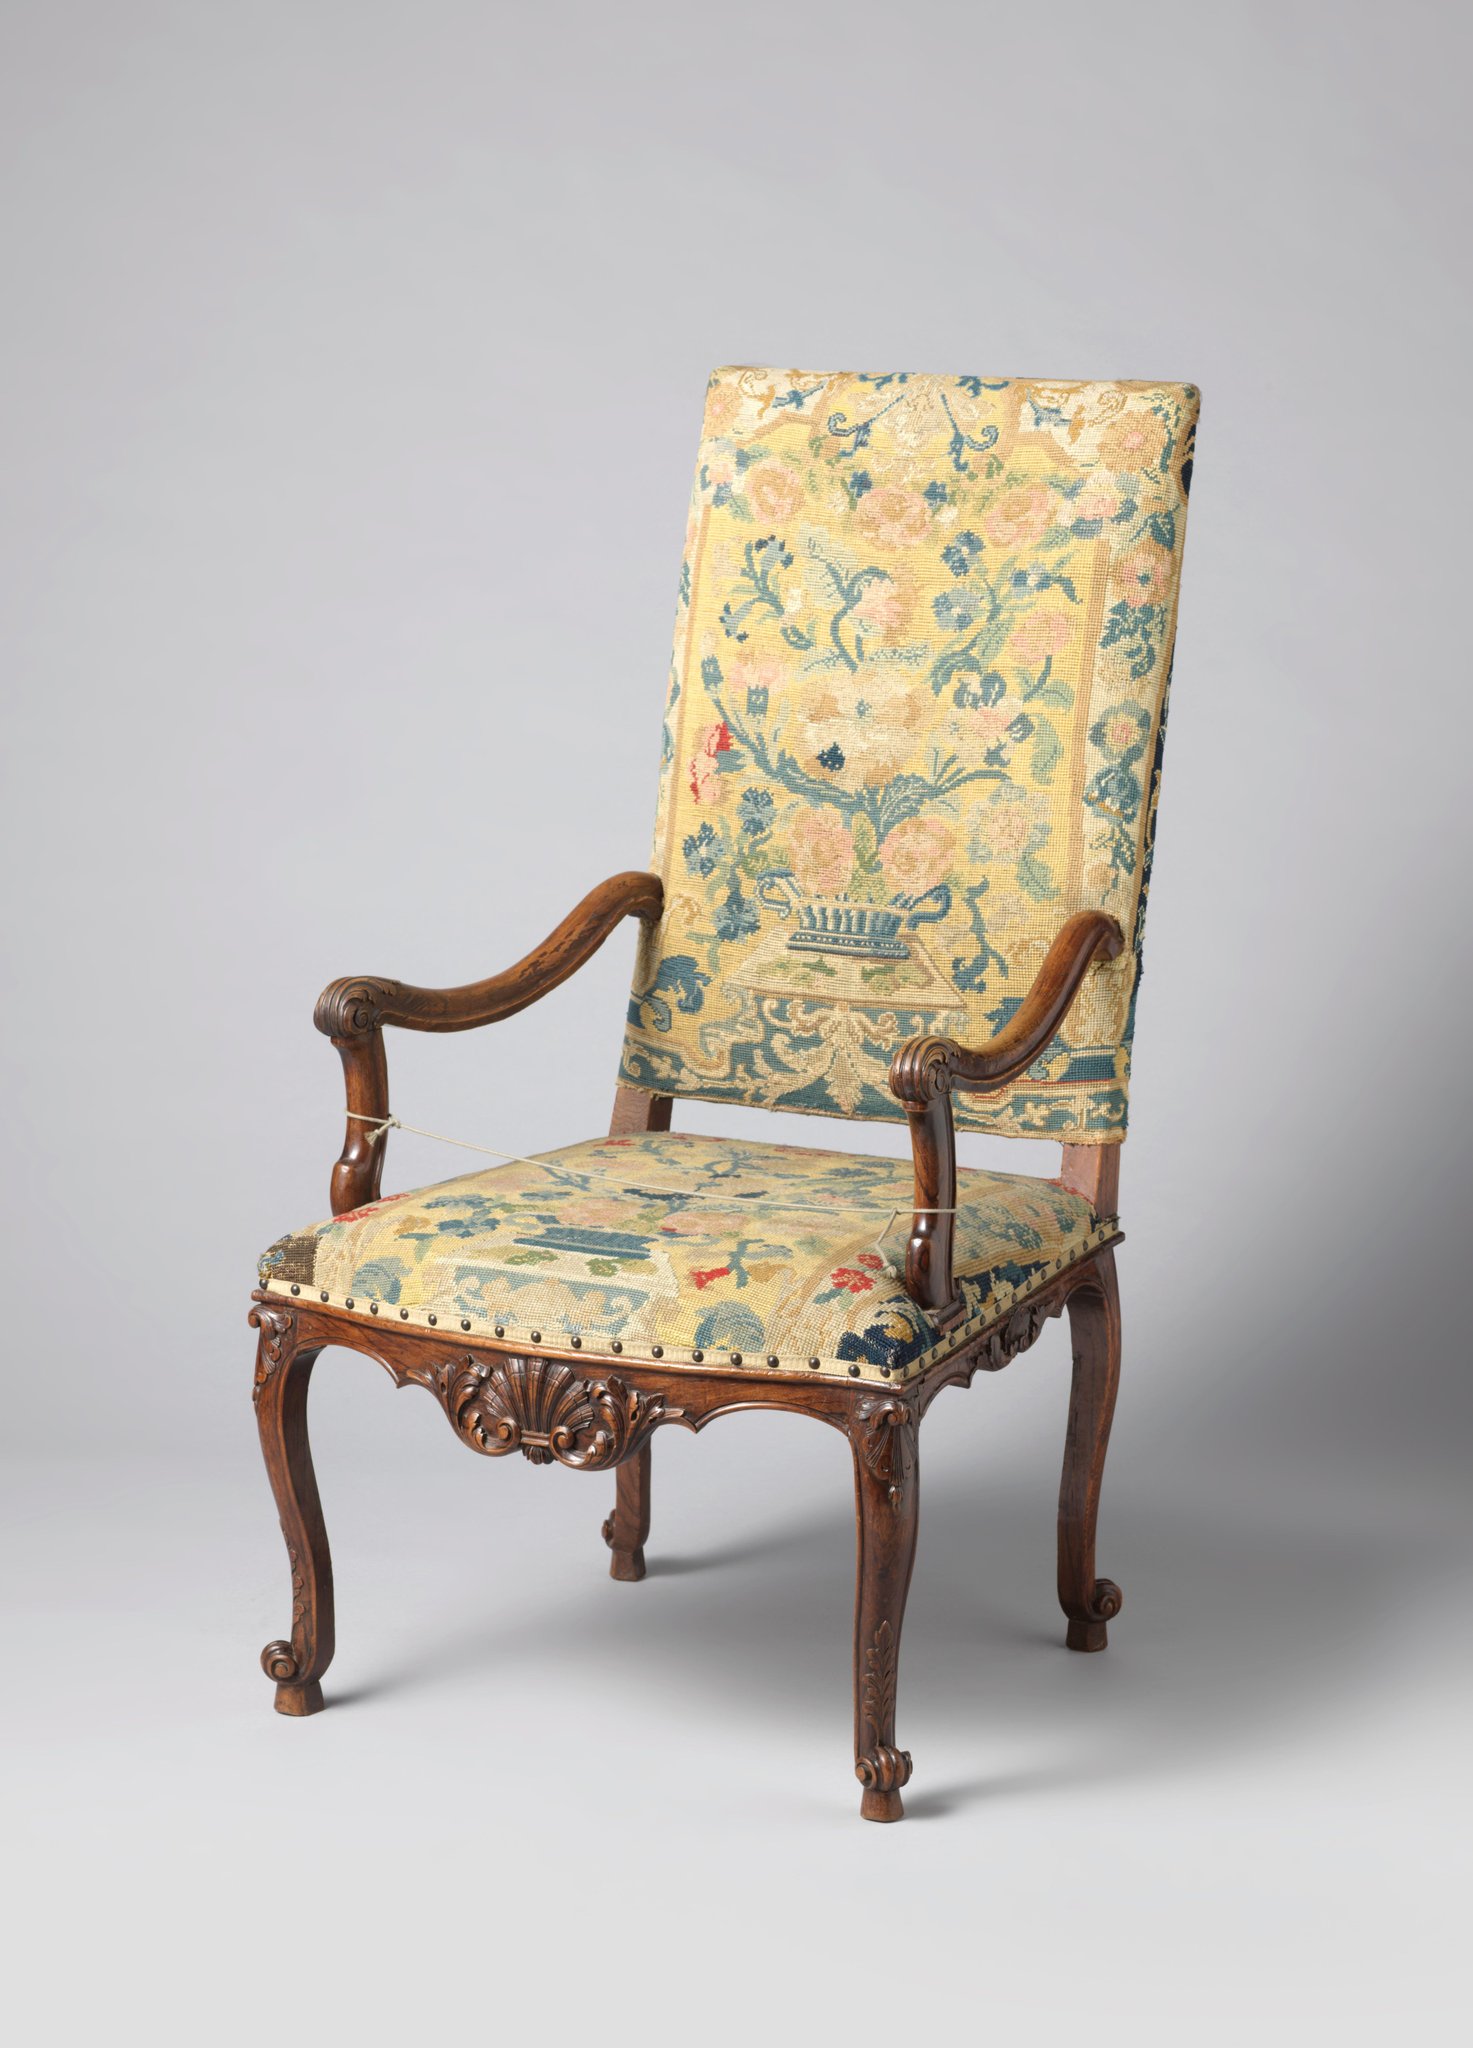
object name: armchair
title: Armstoel van notenhout met petit-point bekleding, oorspronkelijk afkomstig uit Kasteel Eerde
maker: Anonymous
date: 1700-1725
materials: wood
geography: northern netherlands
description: Armstoel van notenhout met petit-point bekleding en eikenhouten rugstijlen en achterpoten. De stoelen rusten op overhoeks geplaatste S-vormige poten. De voorpoten hebben onderaan een voluut met een bladmotief en boven de zwelling een schelpmotief. De armleggerstutten gaan over in geholde armleggers, eindigend in acanthusvoluut. De bekleding vertoont motieven van bloemvazen en - boeketten. Deel van een ameublement van zes armstoelen (inv.nr. BK-16024-a t/m f) , afkomstig uit Kasteel Eerde (O.).